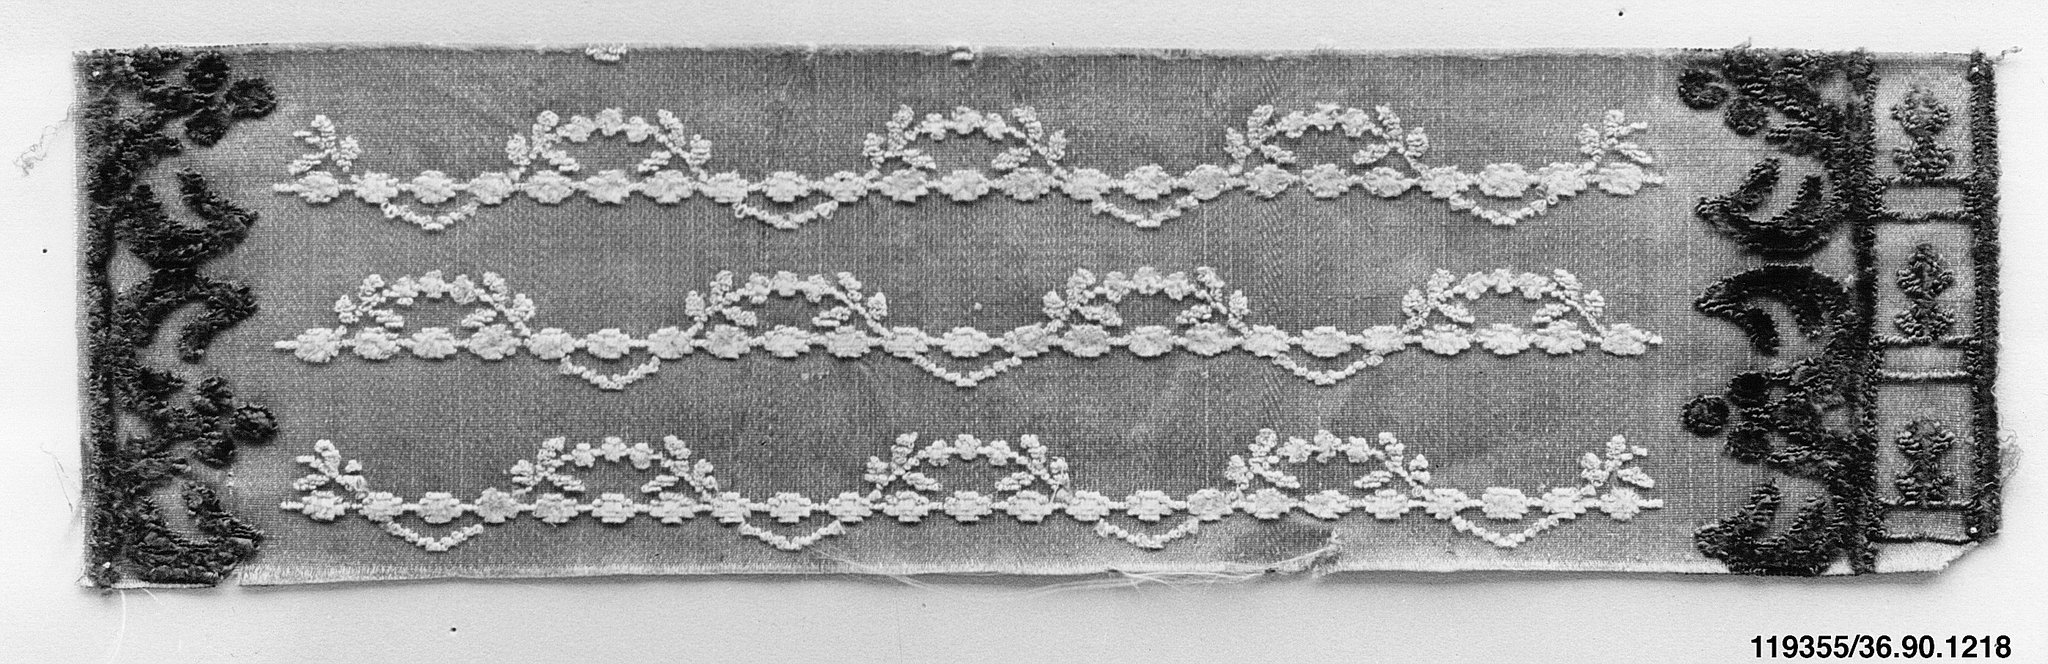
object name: piece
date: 1701-1800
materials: silk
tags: leaves